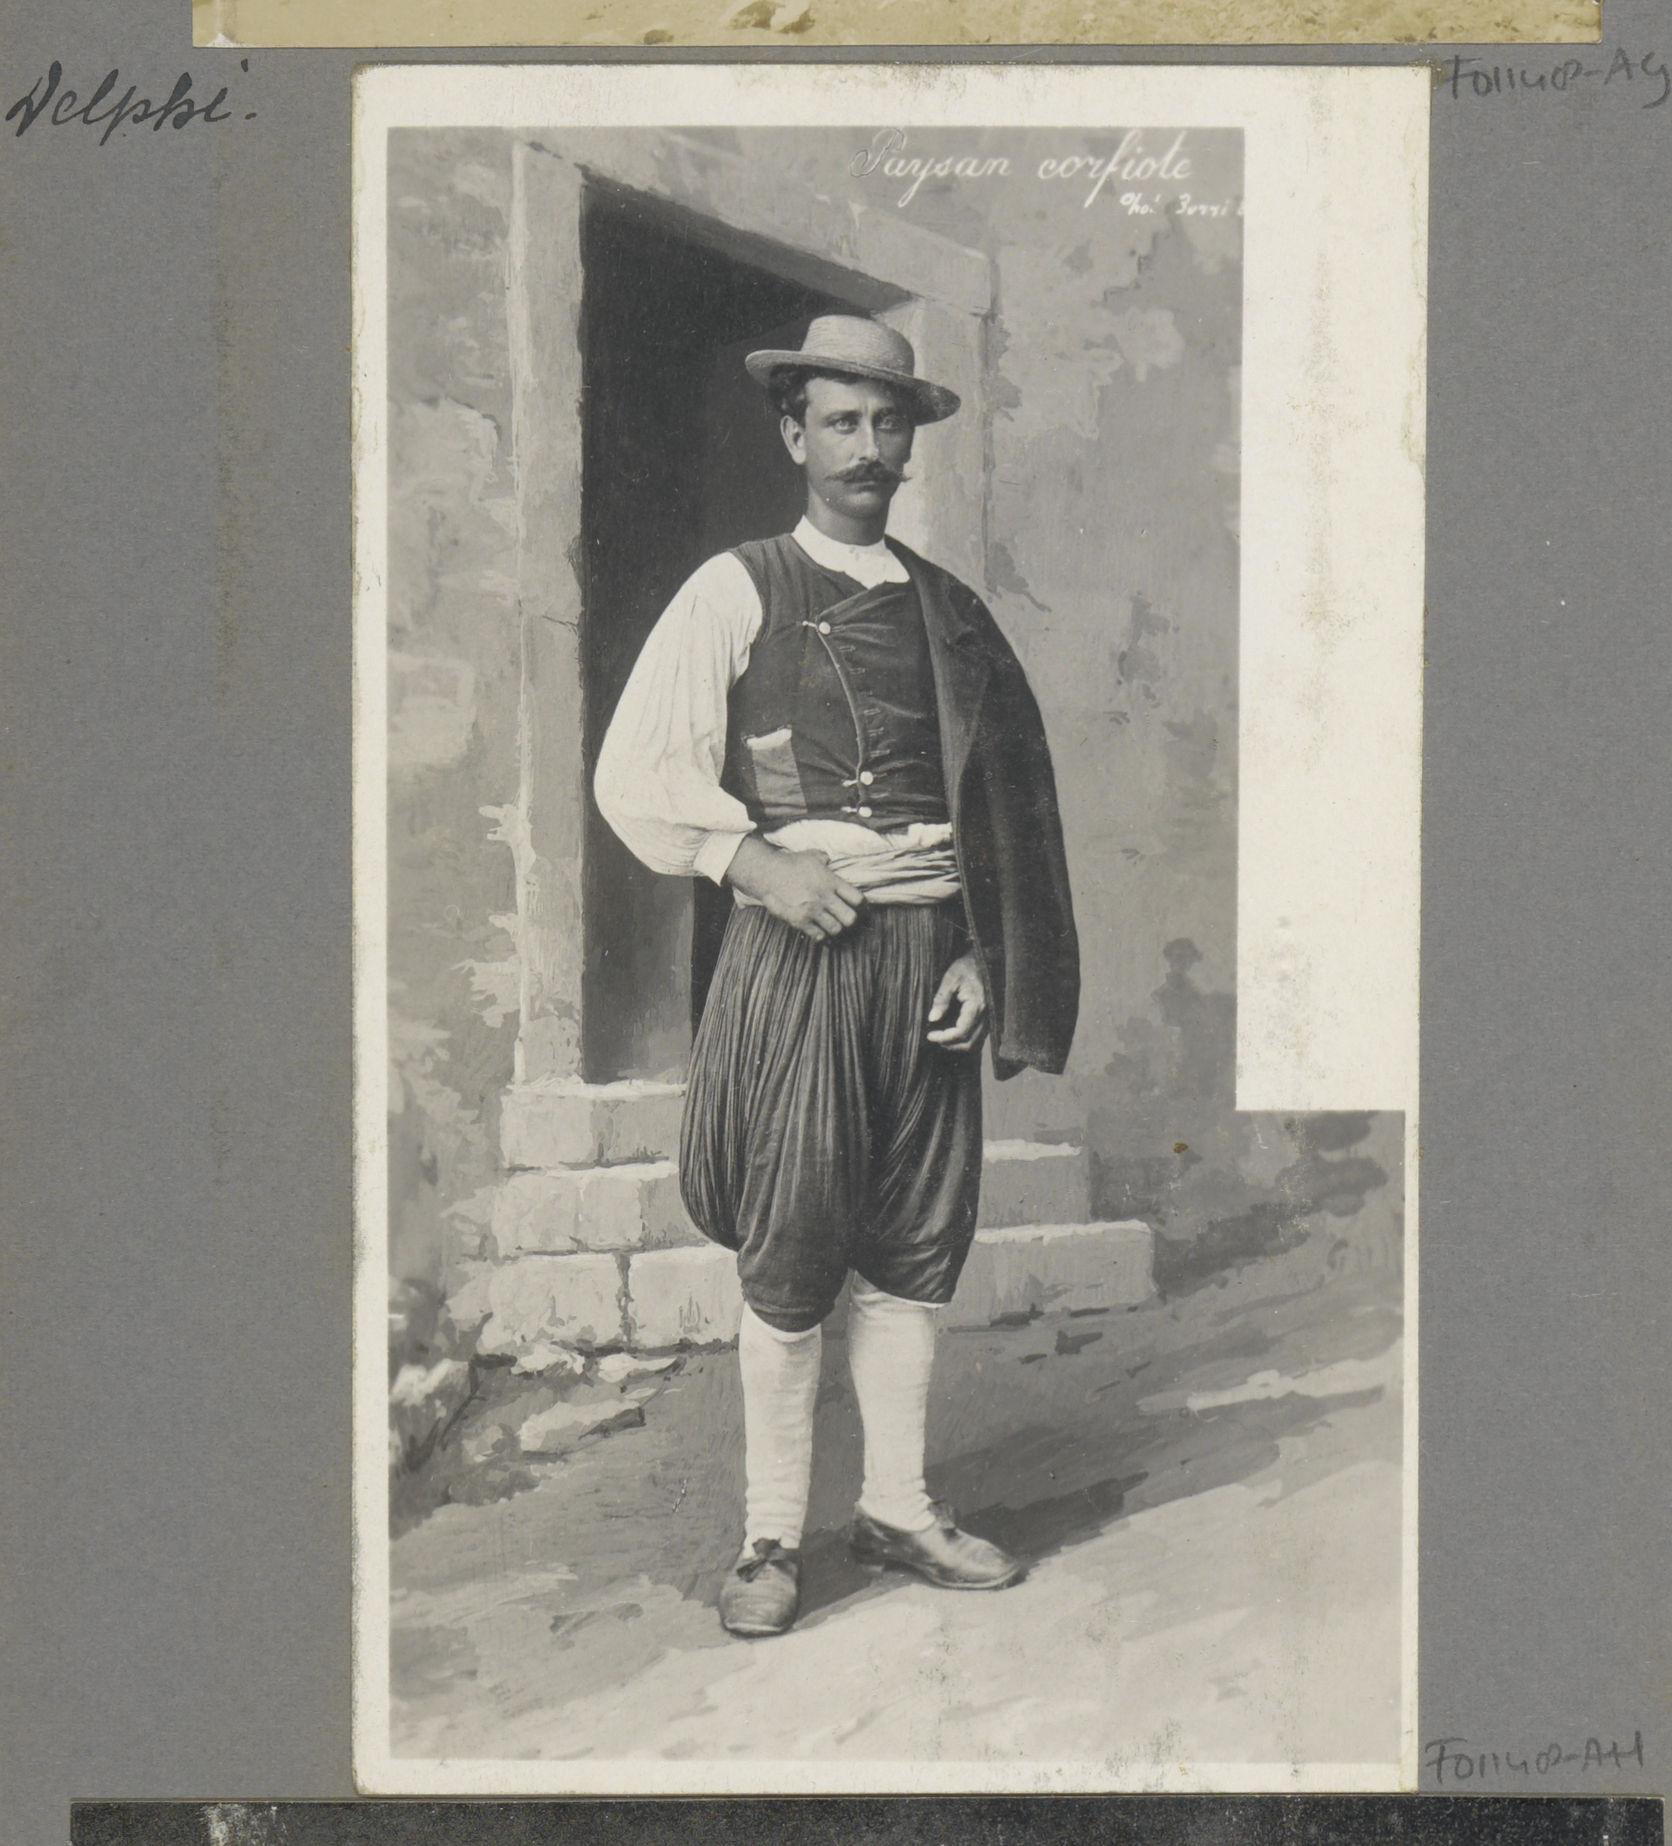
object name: ansichtkaart, prentbriefkaart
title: Paysan corfiote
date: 1895-1905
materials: paper, photographic support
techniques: gelatin silver print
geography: corfu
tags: studio requisites ~ photographer, farmers, folk costume, regional costume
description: Onderdeel van Reisalbum met foto's van bezienswaardigheden in Griekenland en Egypte.